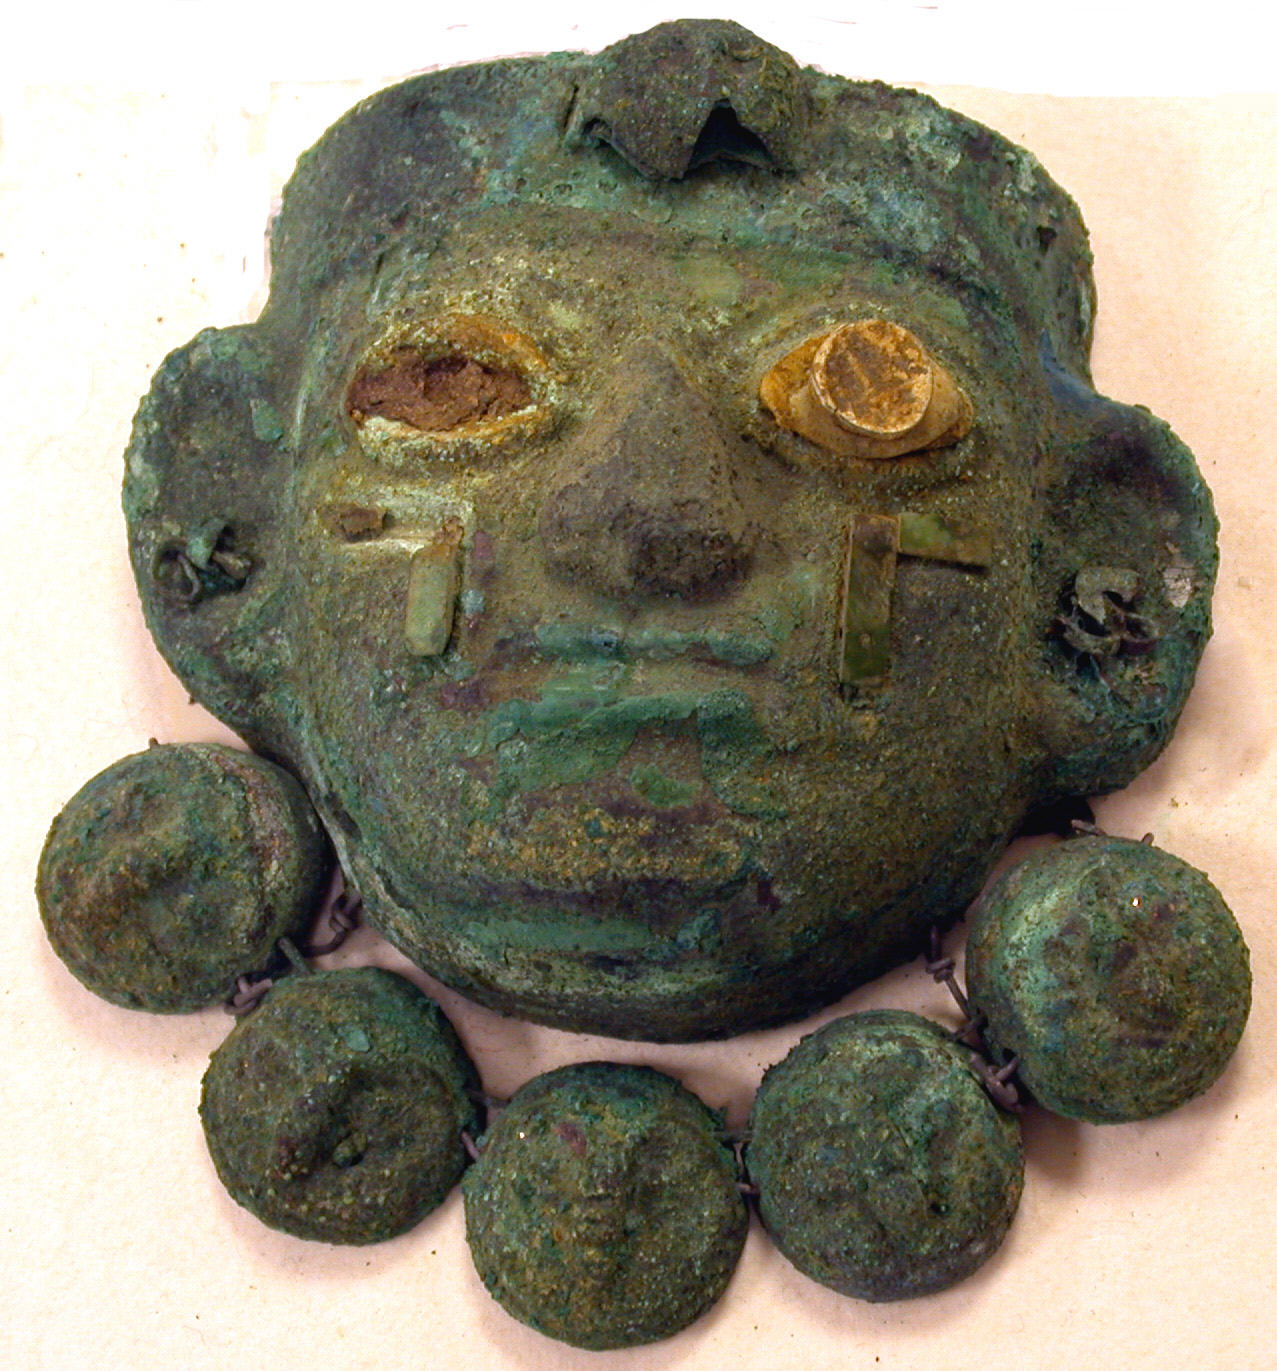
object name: mask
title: Face Mask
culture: moche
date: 501-700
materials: copper, shell, stone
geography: peru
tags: faces